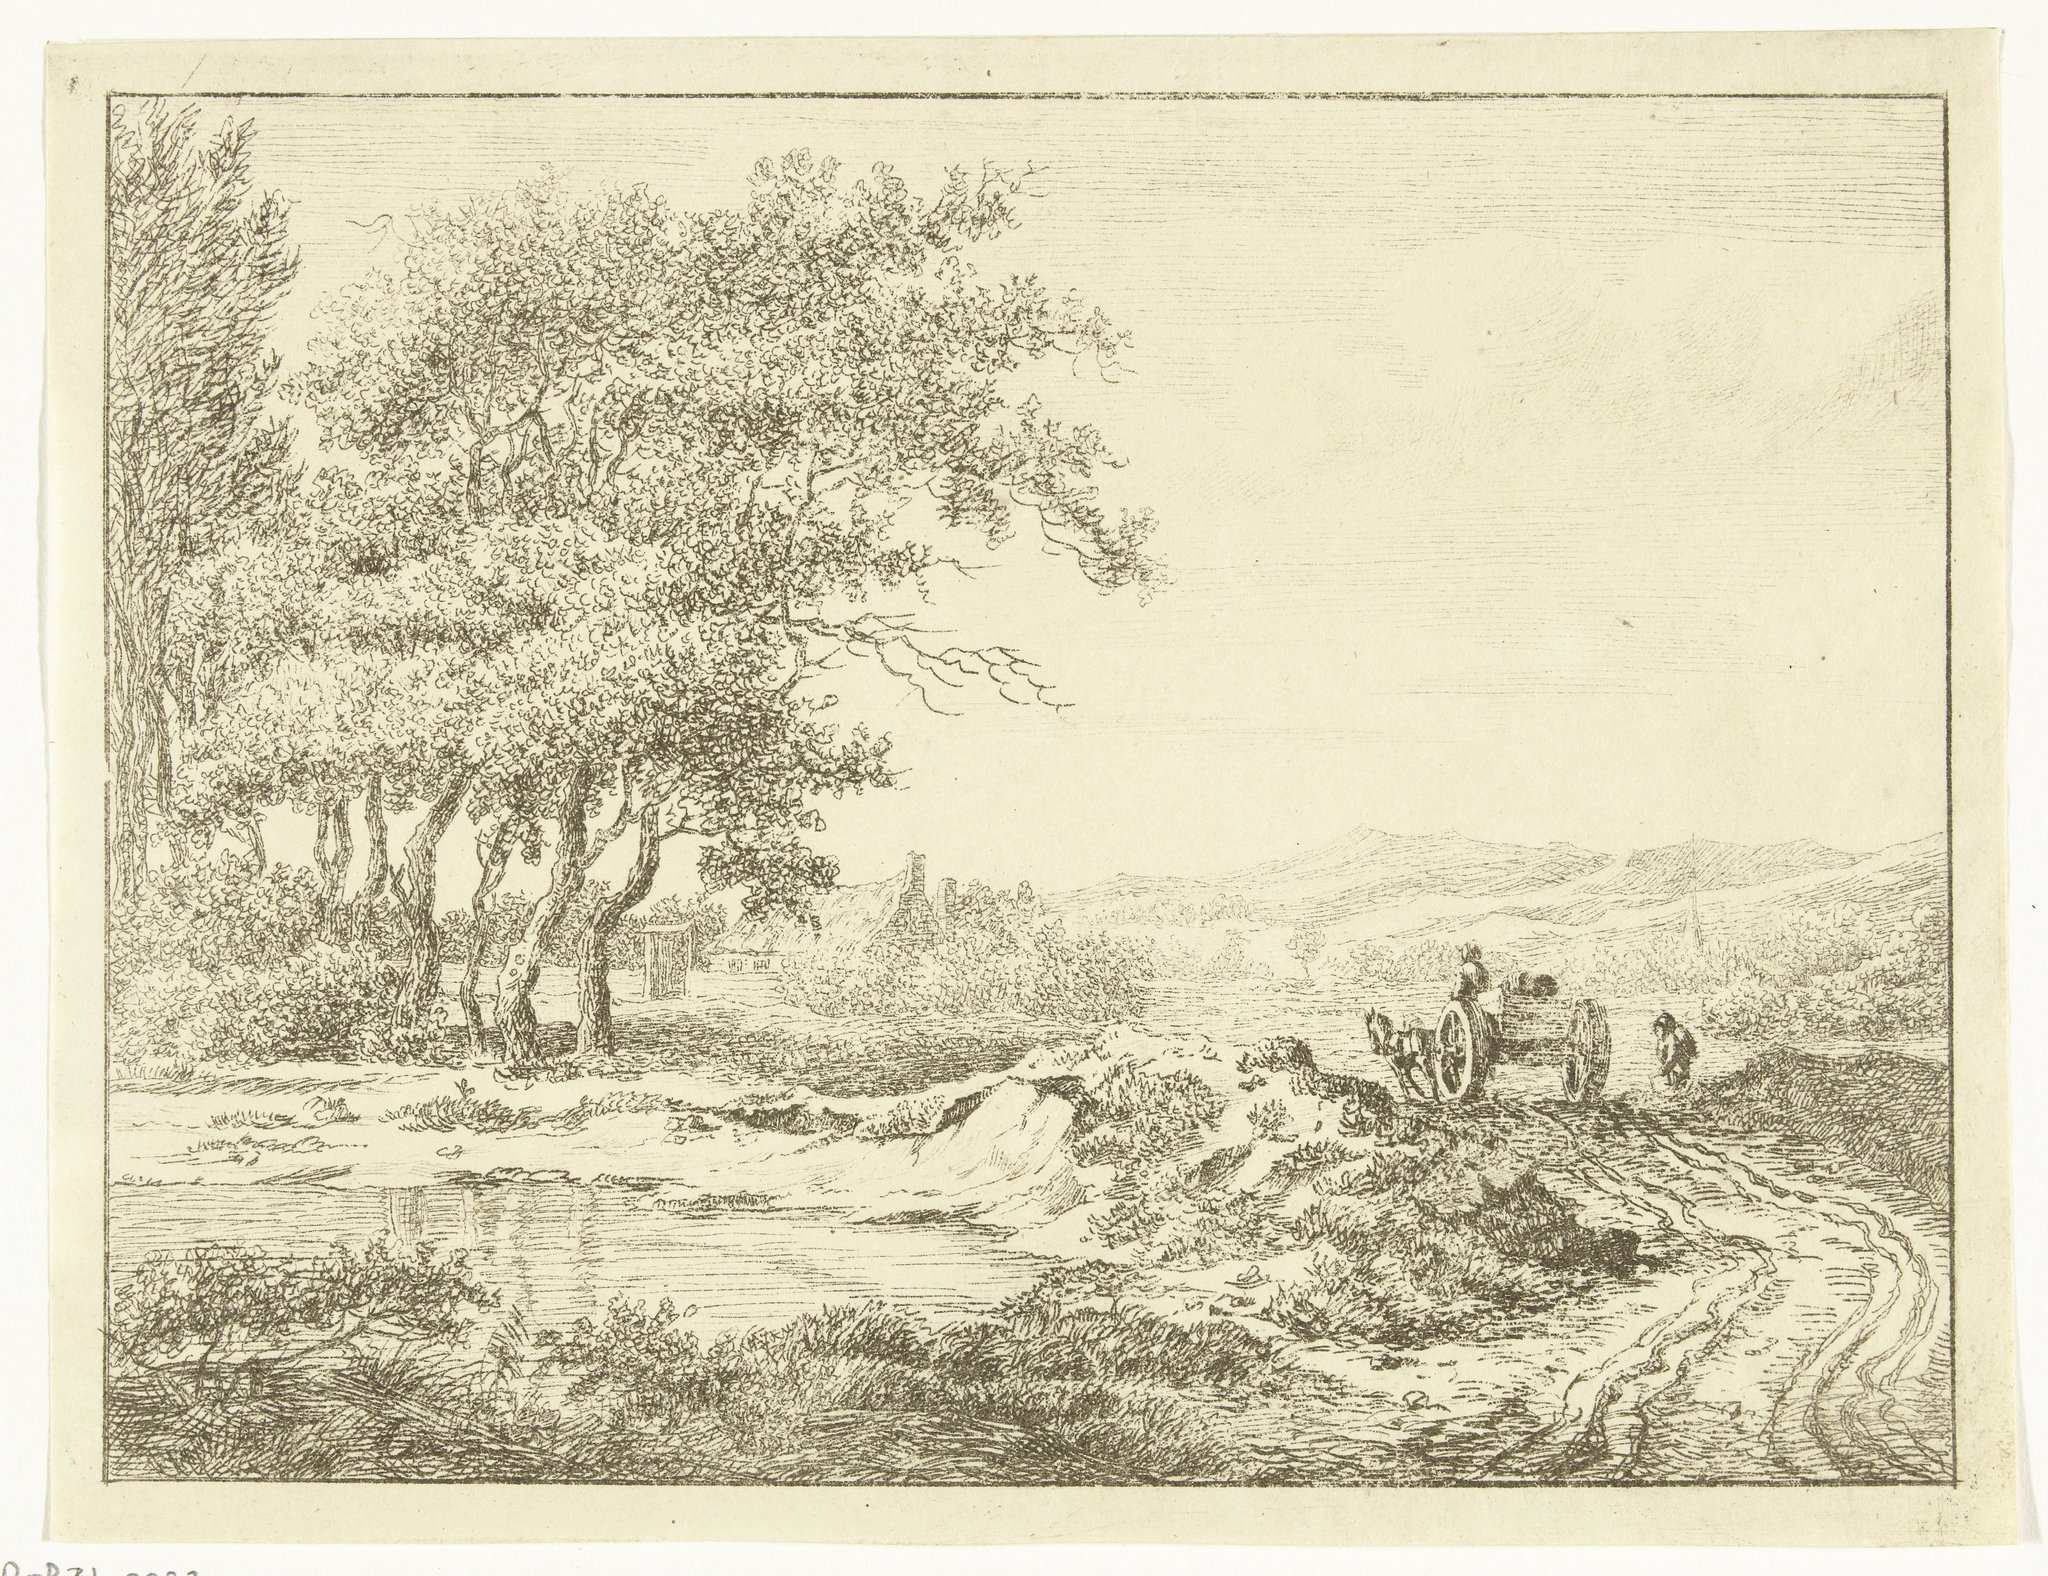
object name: print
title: Kar op een landweg bij de duinen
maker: anthonie van den bos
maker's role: draughtsman, print maker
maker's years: 1763-1838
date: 1778-1838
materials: paper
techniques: printmaking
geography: netherlands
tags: ruin of a dwelling, house, castle, etc.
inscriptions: collector's mark: Lugt 2228